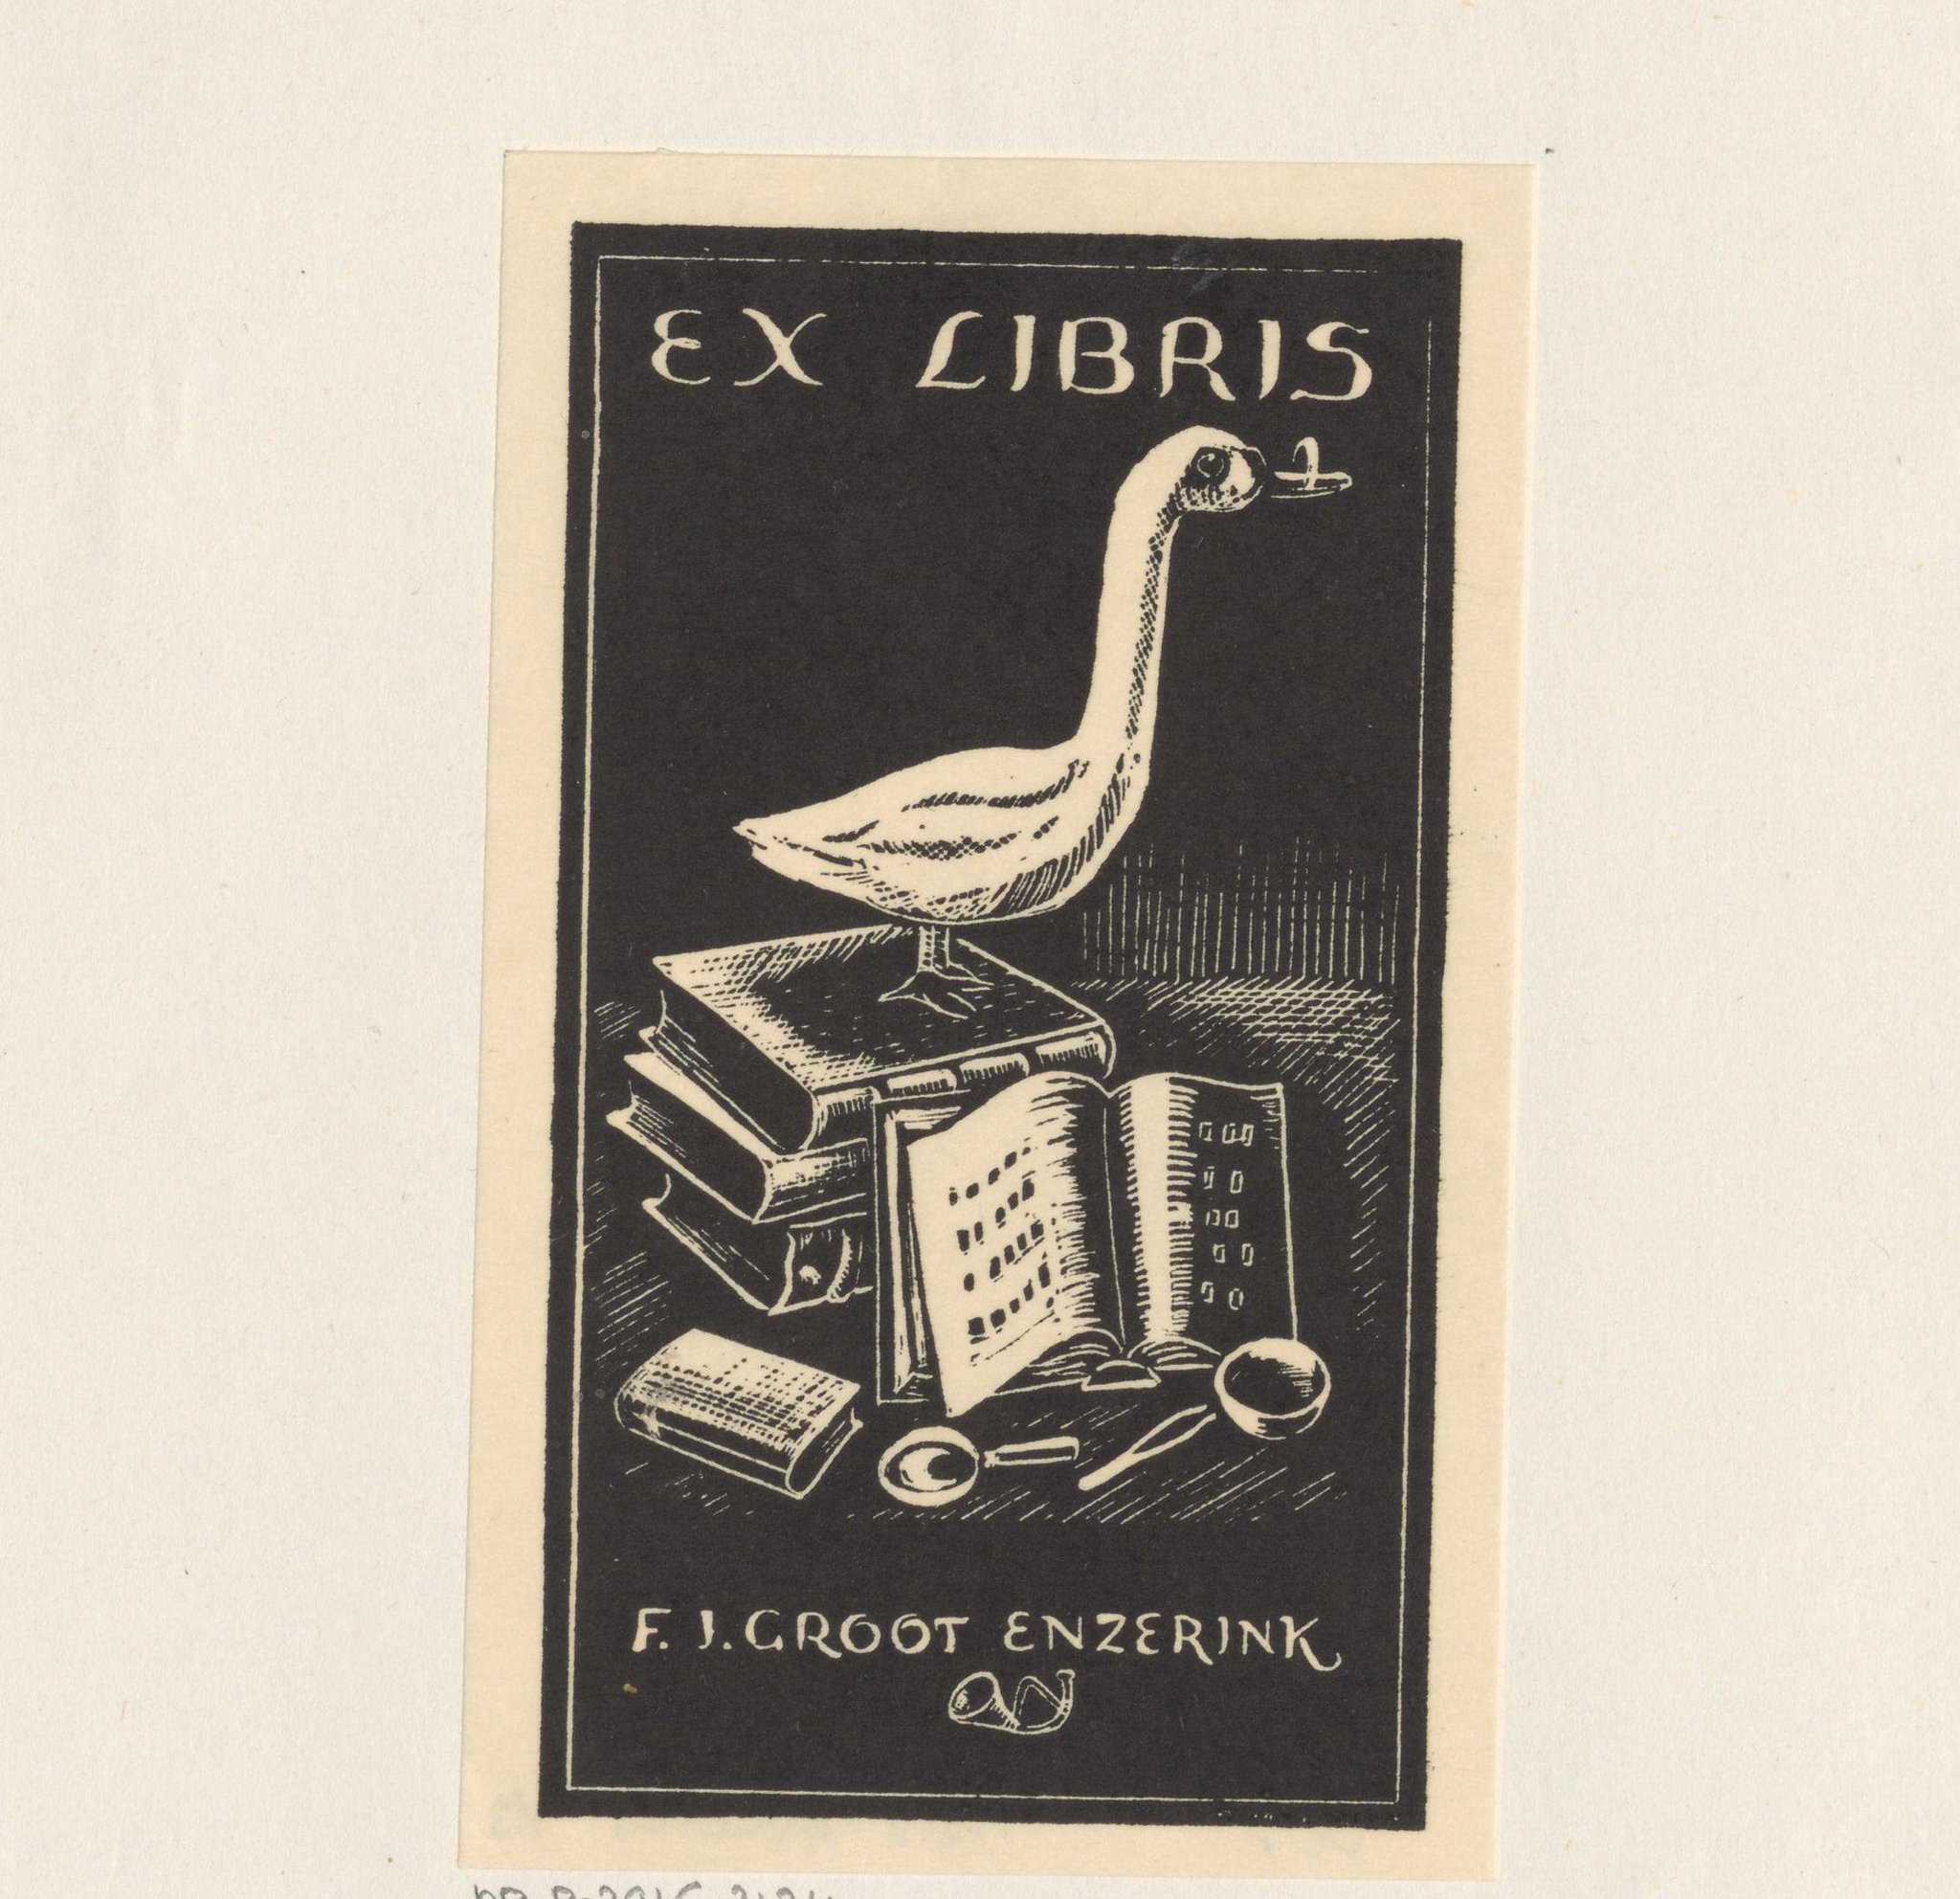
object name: bookplate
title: Ex libris van F.J. Groot Enzerink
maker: w.r.a. van ekelen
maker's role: painter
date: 1943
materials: paper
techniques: printing block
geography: netherlands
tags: mayor, collecting (leisure time activity), stamp (~ postal matter), water-birds: goose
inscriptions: inscription: ‘Cl. / W. van Ekelen '43’